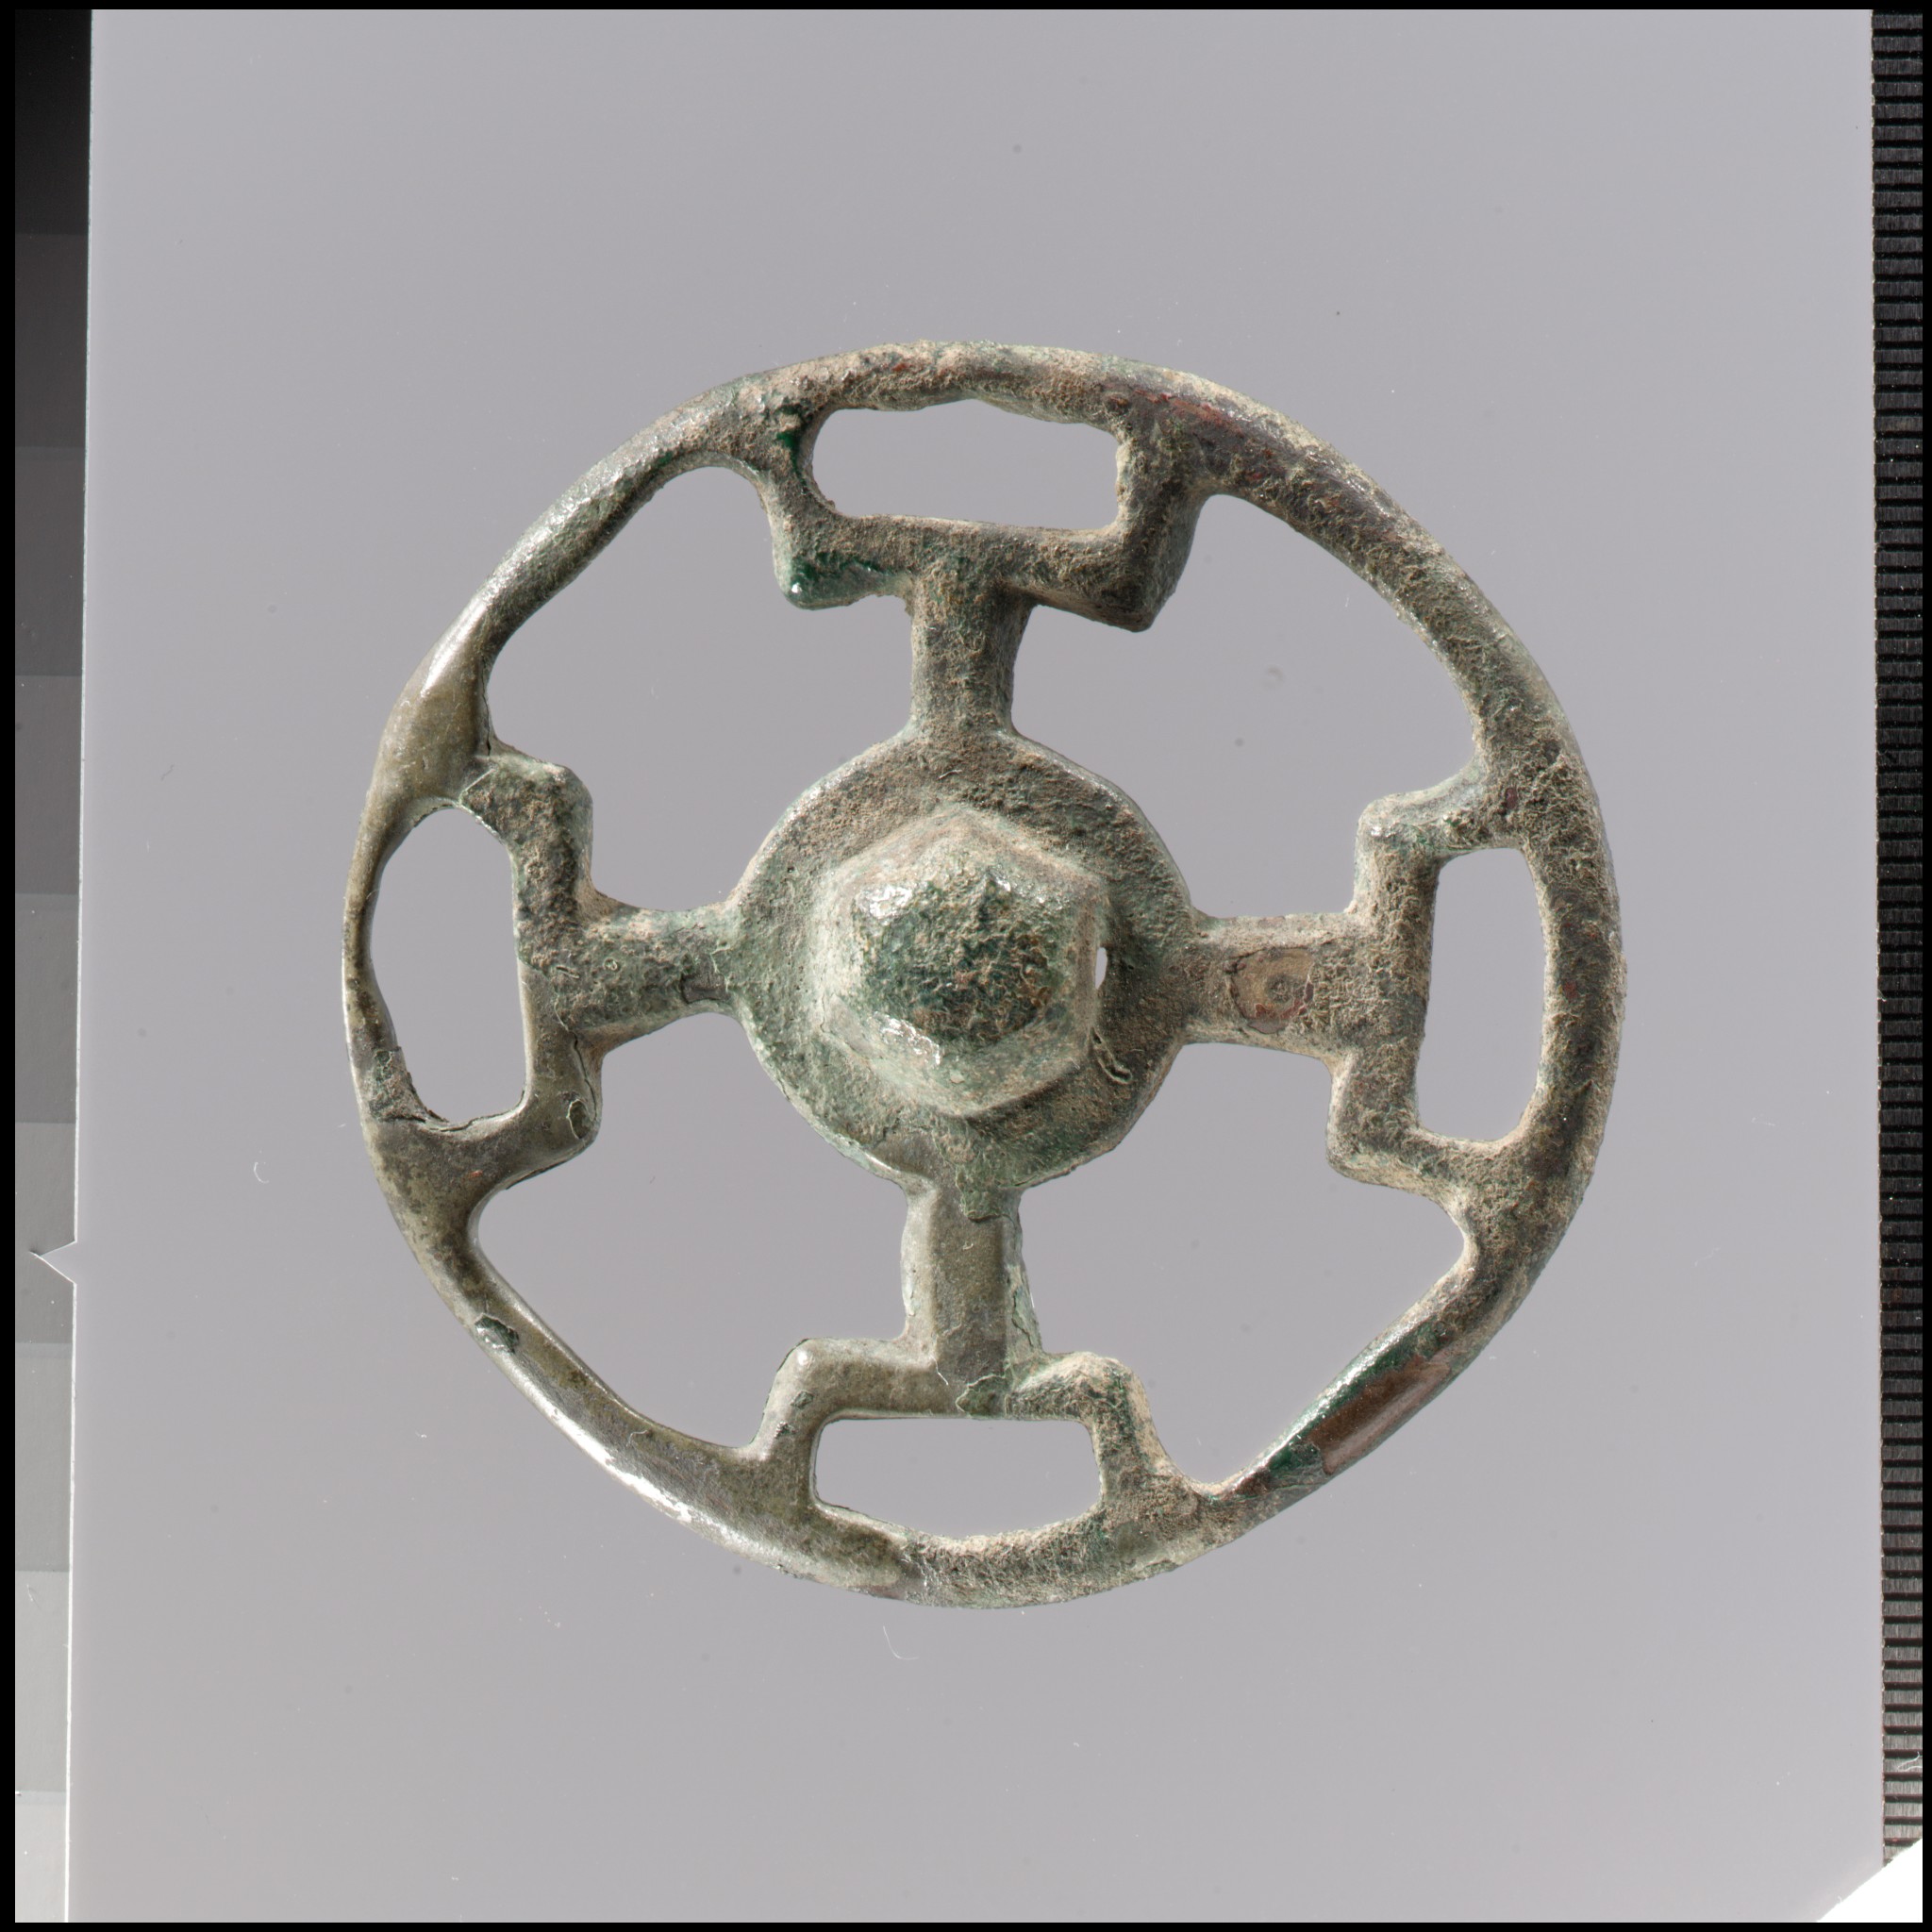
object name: plaque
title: Openwork Belt Fitting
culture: frankish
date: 501-600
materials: copper alloy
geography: france